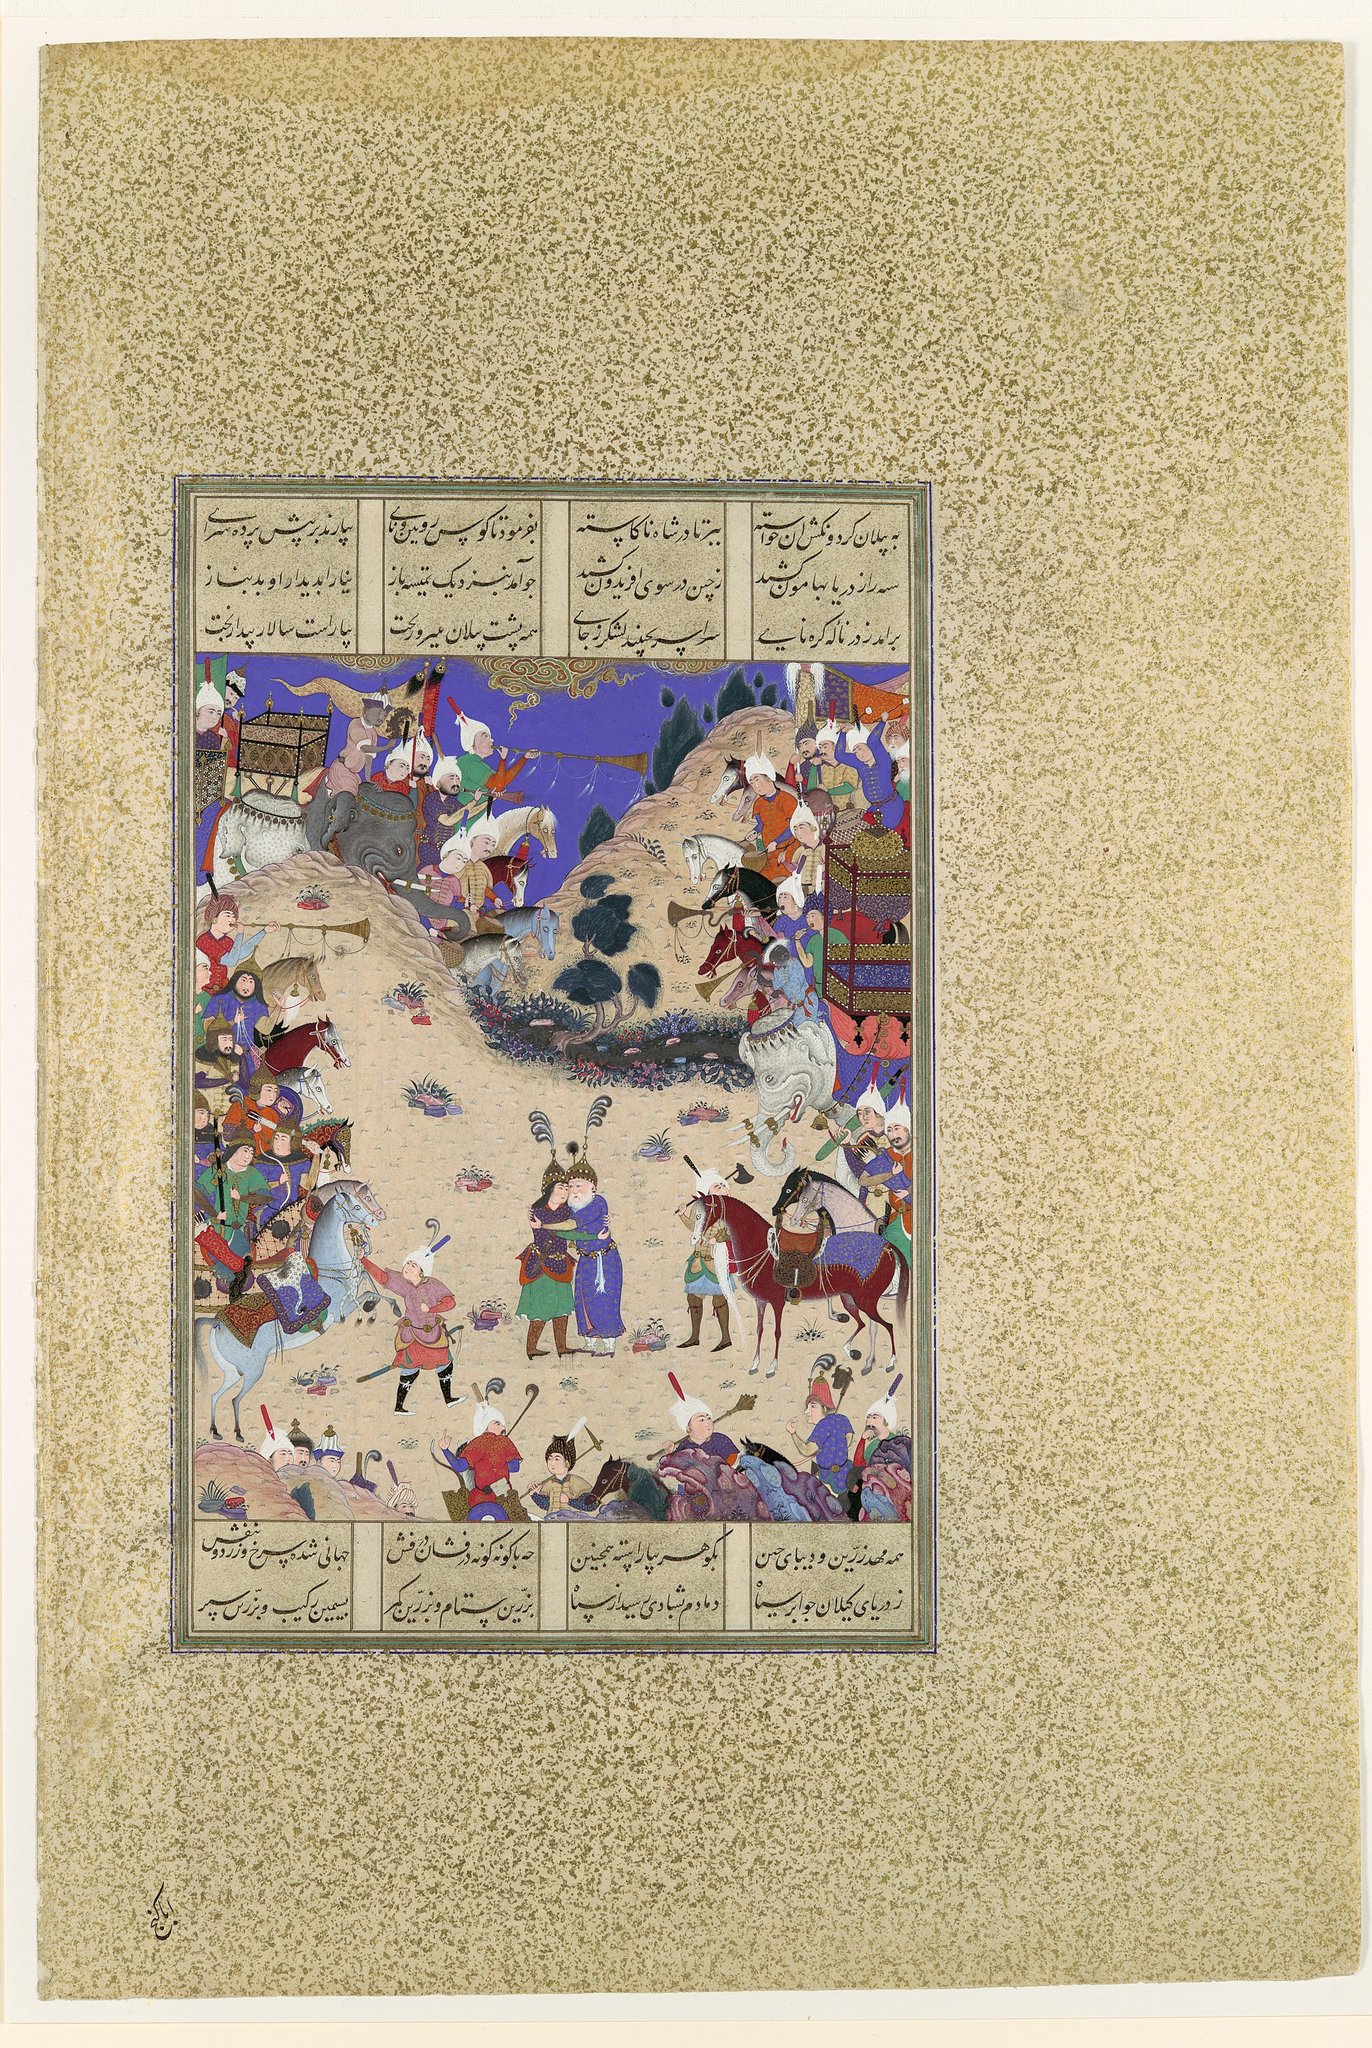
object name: folio from an illustrated manuscript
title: "Faridun Embraces Manuchihr", Folio 59v from the Shahnama (Book of Kings) of Shah Tahmasp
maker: abu'l qasim firdausi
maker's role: author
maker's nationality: iranian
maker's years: 935-1020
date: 1525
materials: gold, ink, paper, silver, watercolor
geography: iran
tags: men,elephants,horses